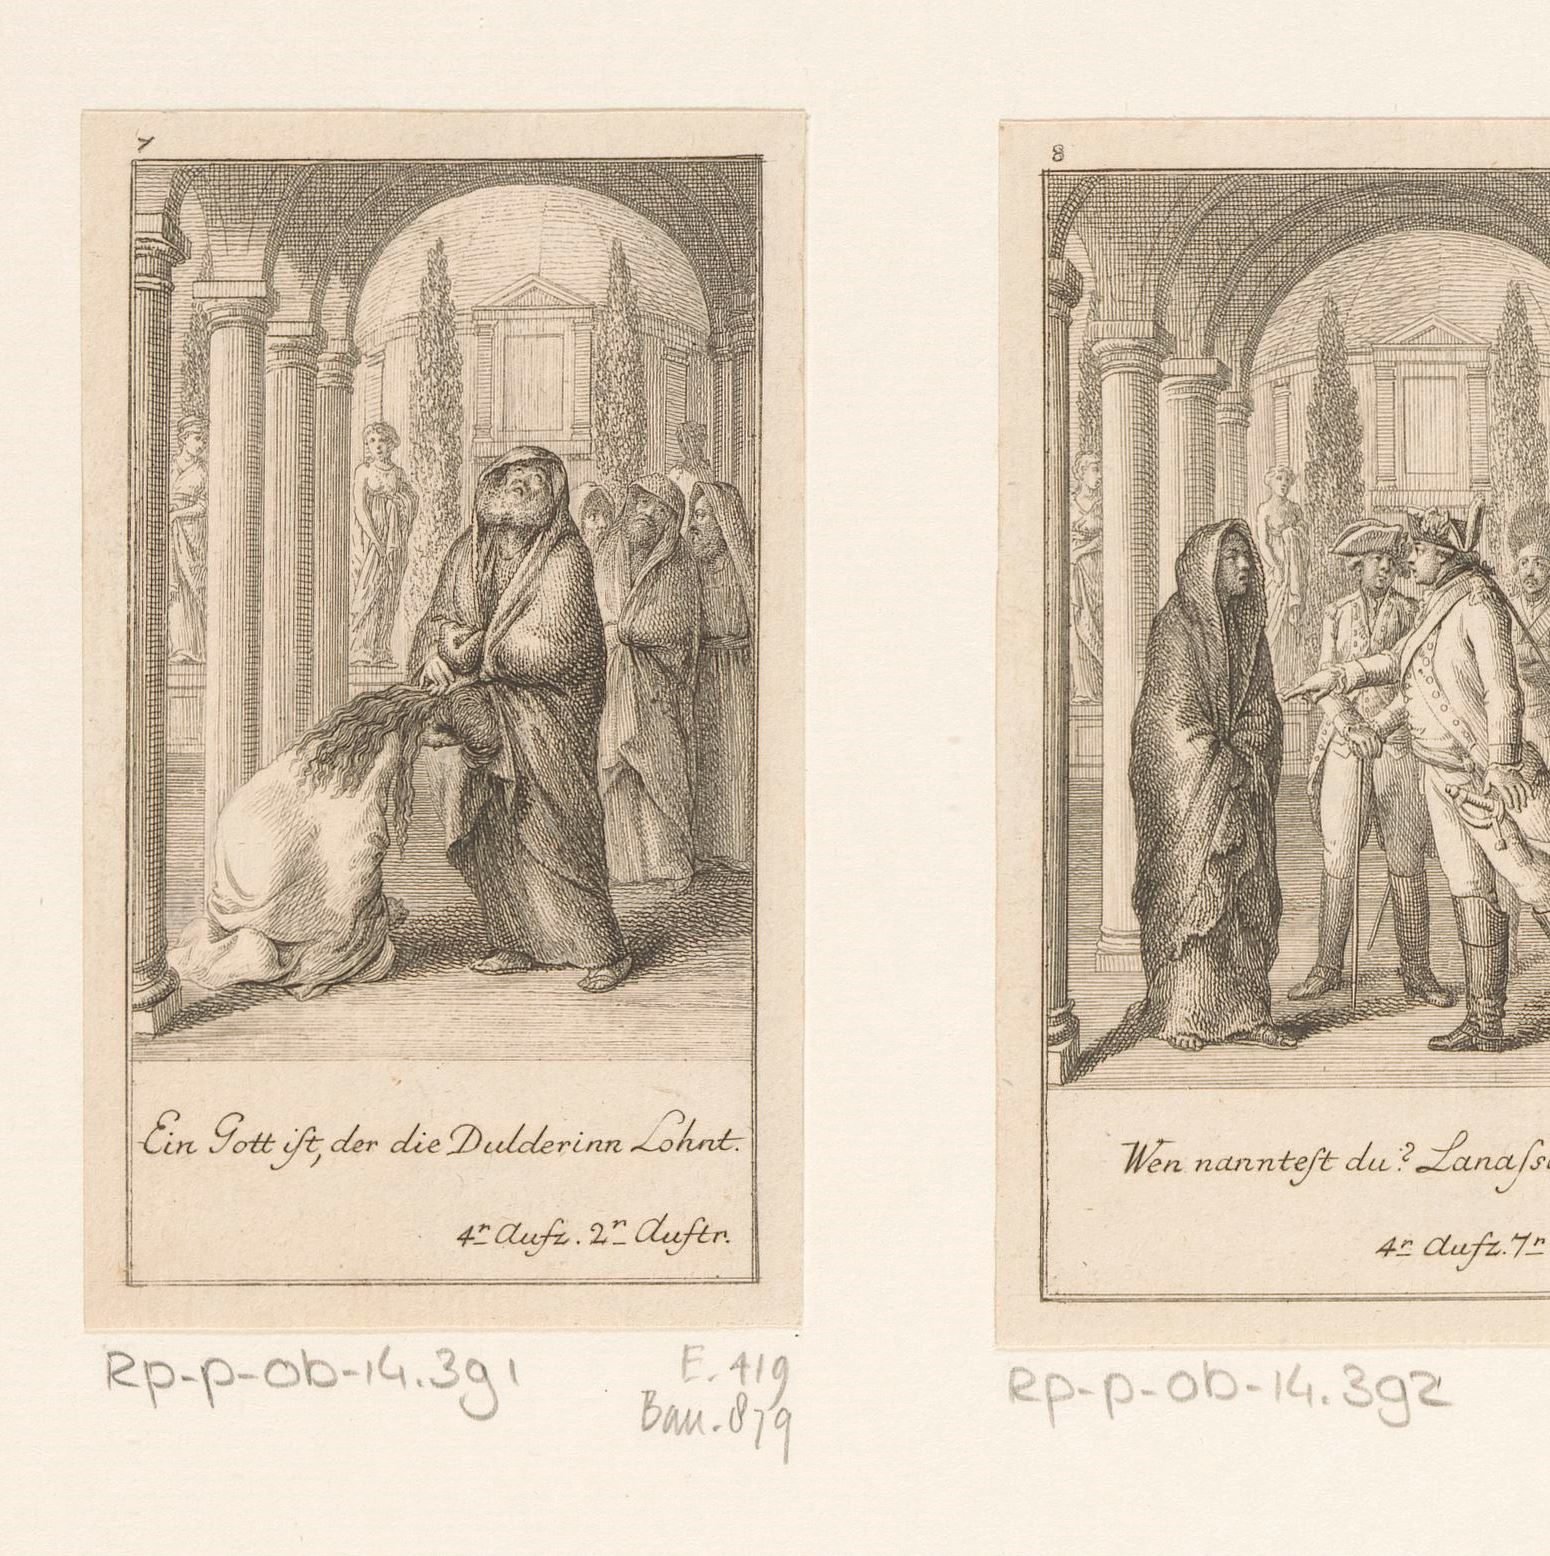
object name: print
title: Lanassa vertelt de brahmaan haar laatste wens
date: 1782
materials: paper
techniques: etching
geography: berlin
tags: trees: cypress, kneeling figure - aa - female human figure, literature, priest ~ non-christian religions, temple, shrine ~ non-christian religions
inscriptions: collector's mark: Lugt 2228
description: Vervaardigd voor Karl Martin Plümicke's 'Lanassa'. Prent gebruikt voor: Köningl. Grosbr. Genealogischer Kalender auf das 1783 Jahr. Lauenburg: J. G. Berenberg, 1782.